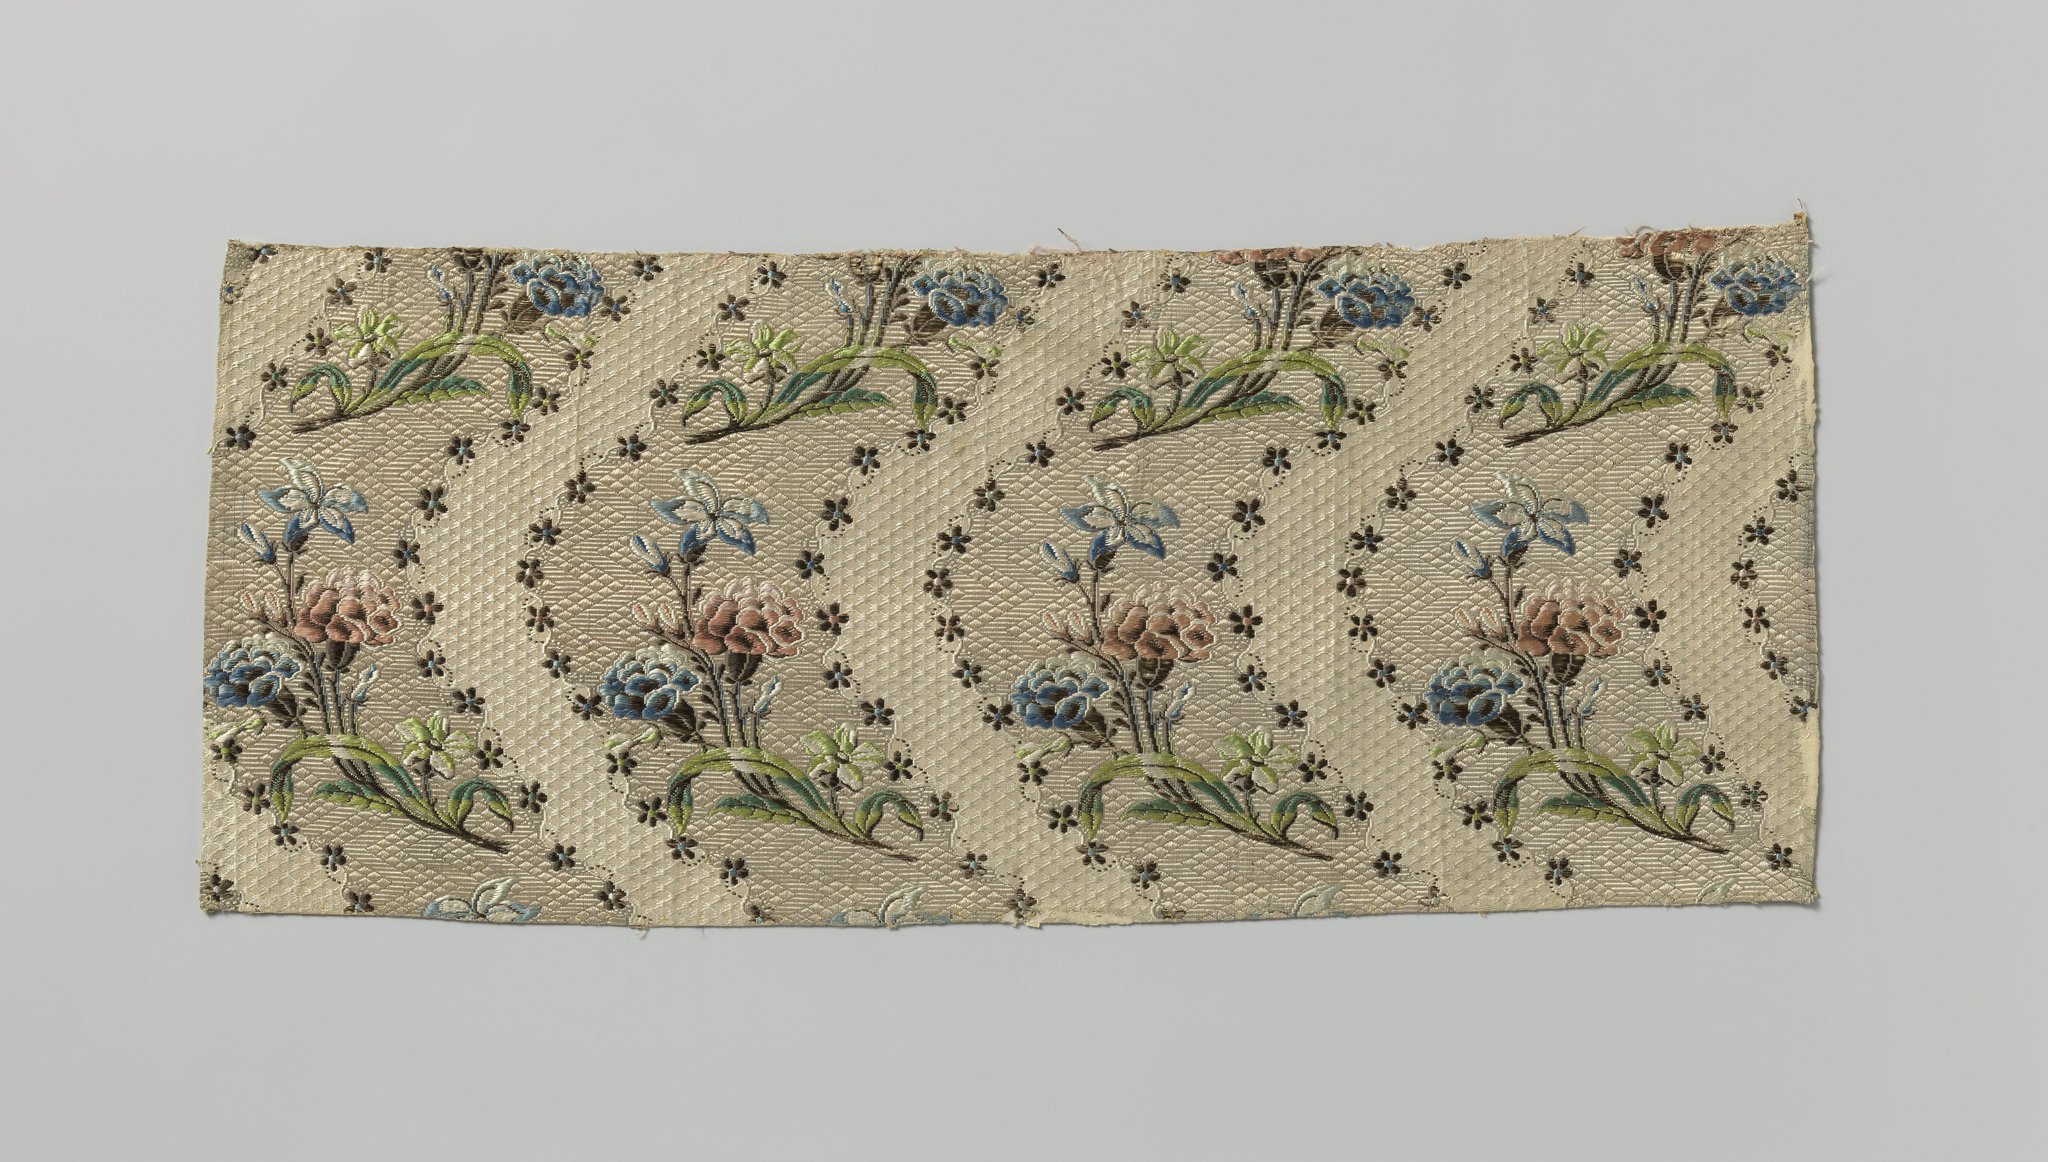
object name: fragment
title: Fragment veelkleurig zijden droguet liseré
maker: Anonymous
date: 1740-1760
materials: silk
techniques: droguet liseré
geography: germany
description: Een fragment van zalmkleurige zijde, waarop geslingerde witte banden als kant met zwarte sterretjes. Opmerking: Zelfkanten: Matjes binding 0.4 cm.